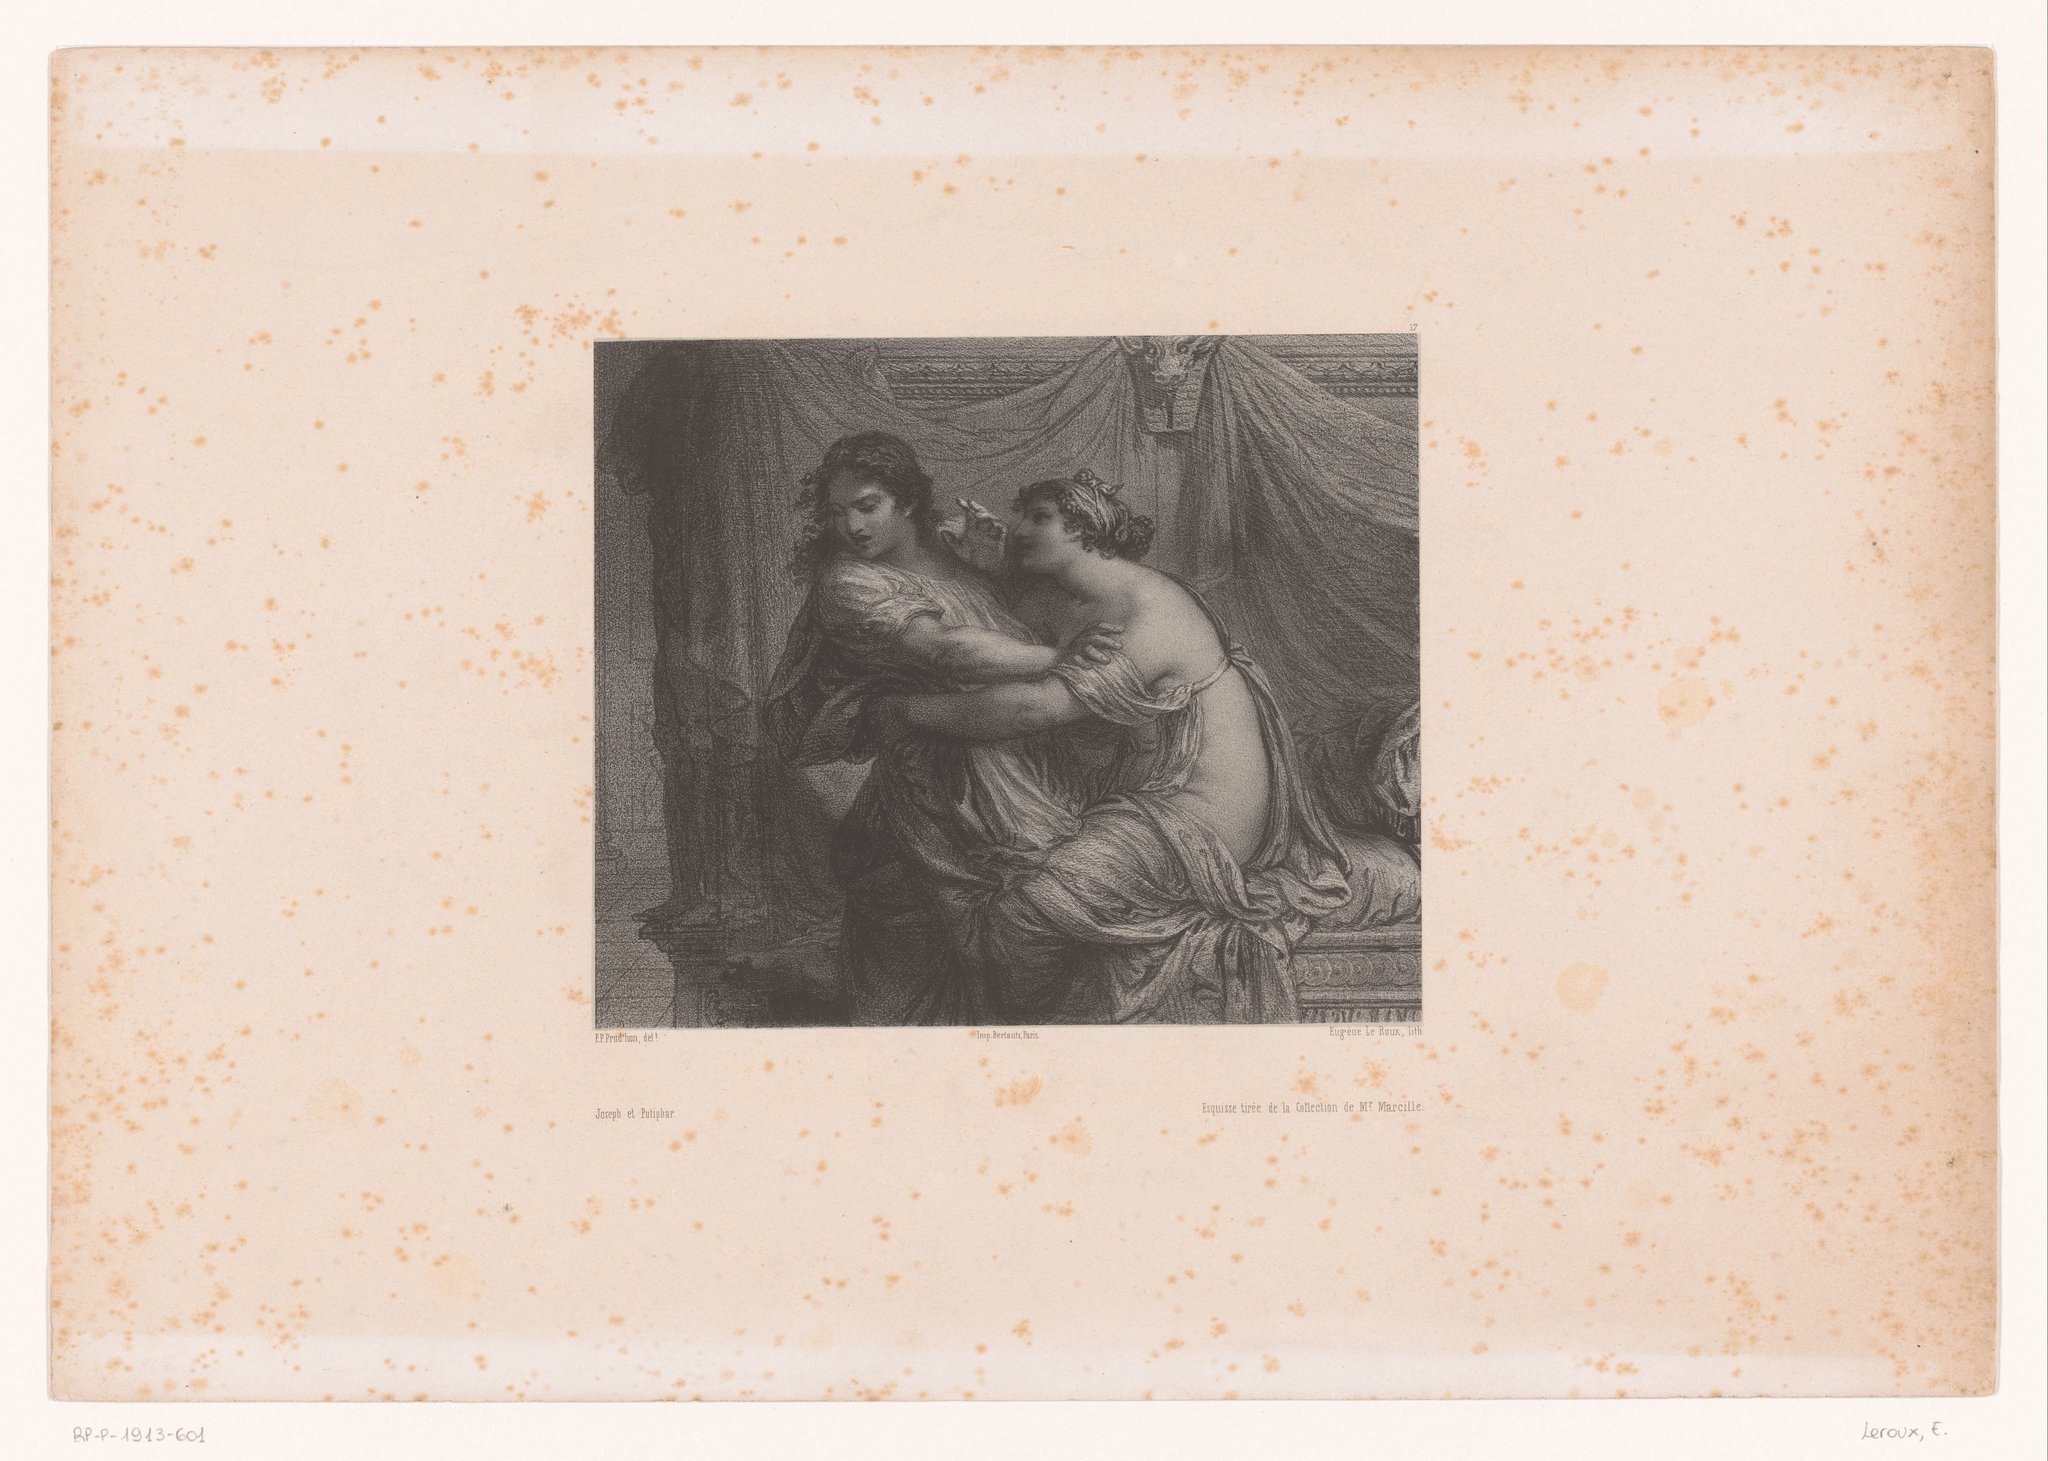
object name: print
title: Jozef en de vrouw van Potifar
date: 1850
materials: paper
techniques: lithography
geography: paris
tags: potiphar's wife catches joseph by his robe, usually while lying in bed; joseph escapes leaving his cloak behind in her hands (possibly with a naked child lying in a crib)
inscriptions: collector's mark: Lugt 2233, check stamp: Lugt 36a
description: Prent gebruikt voor: Les Artistes anciens et modernes, dl. 1, 1850.